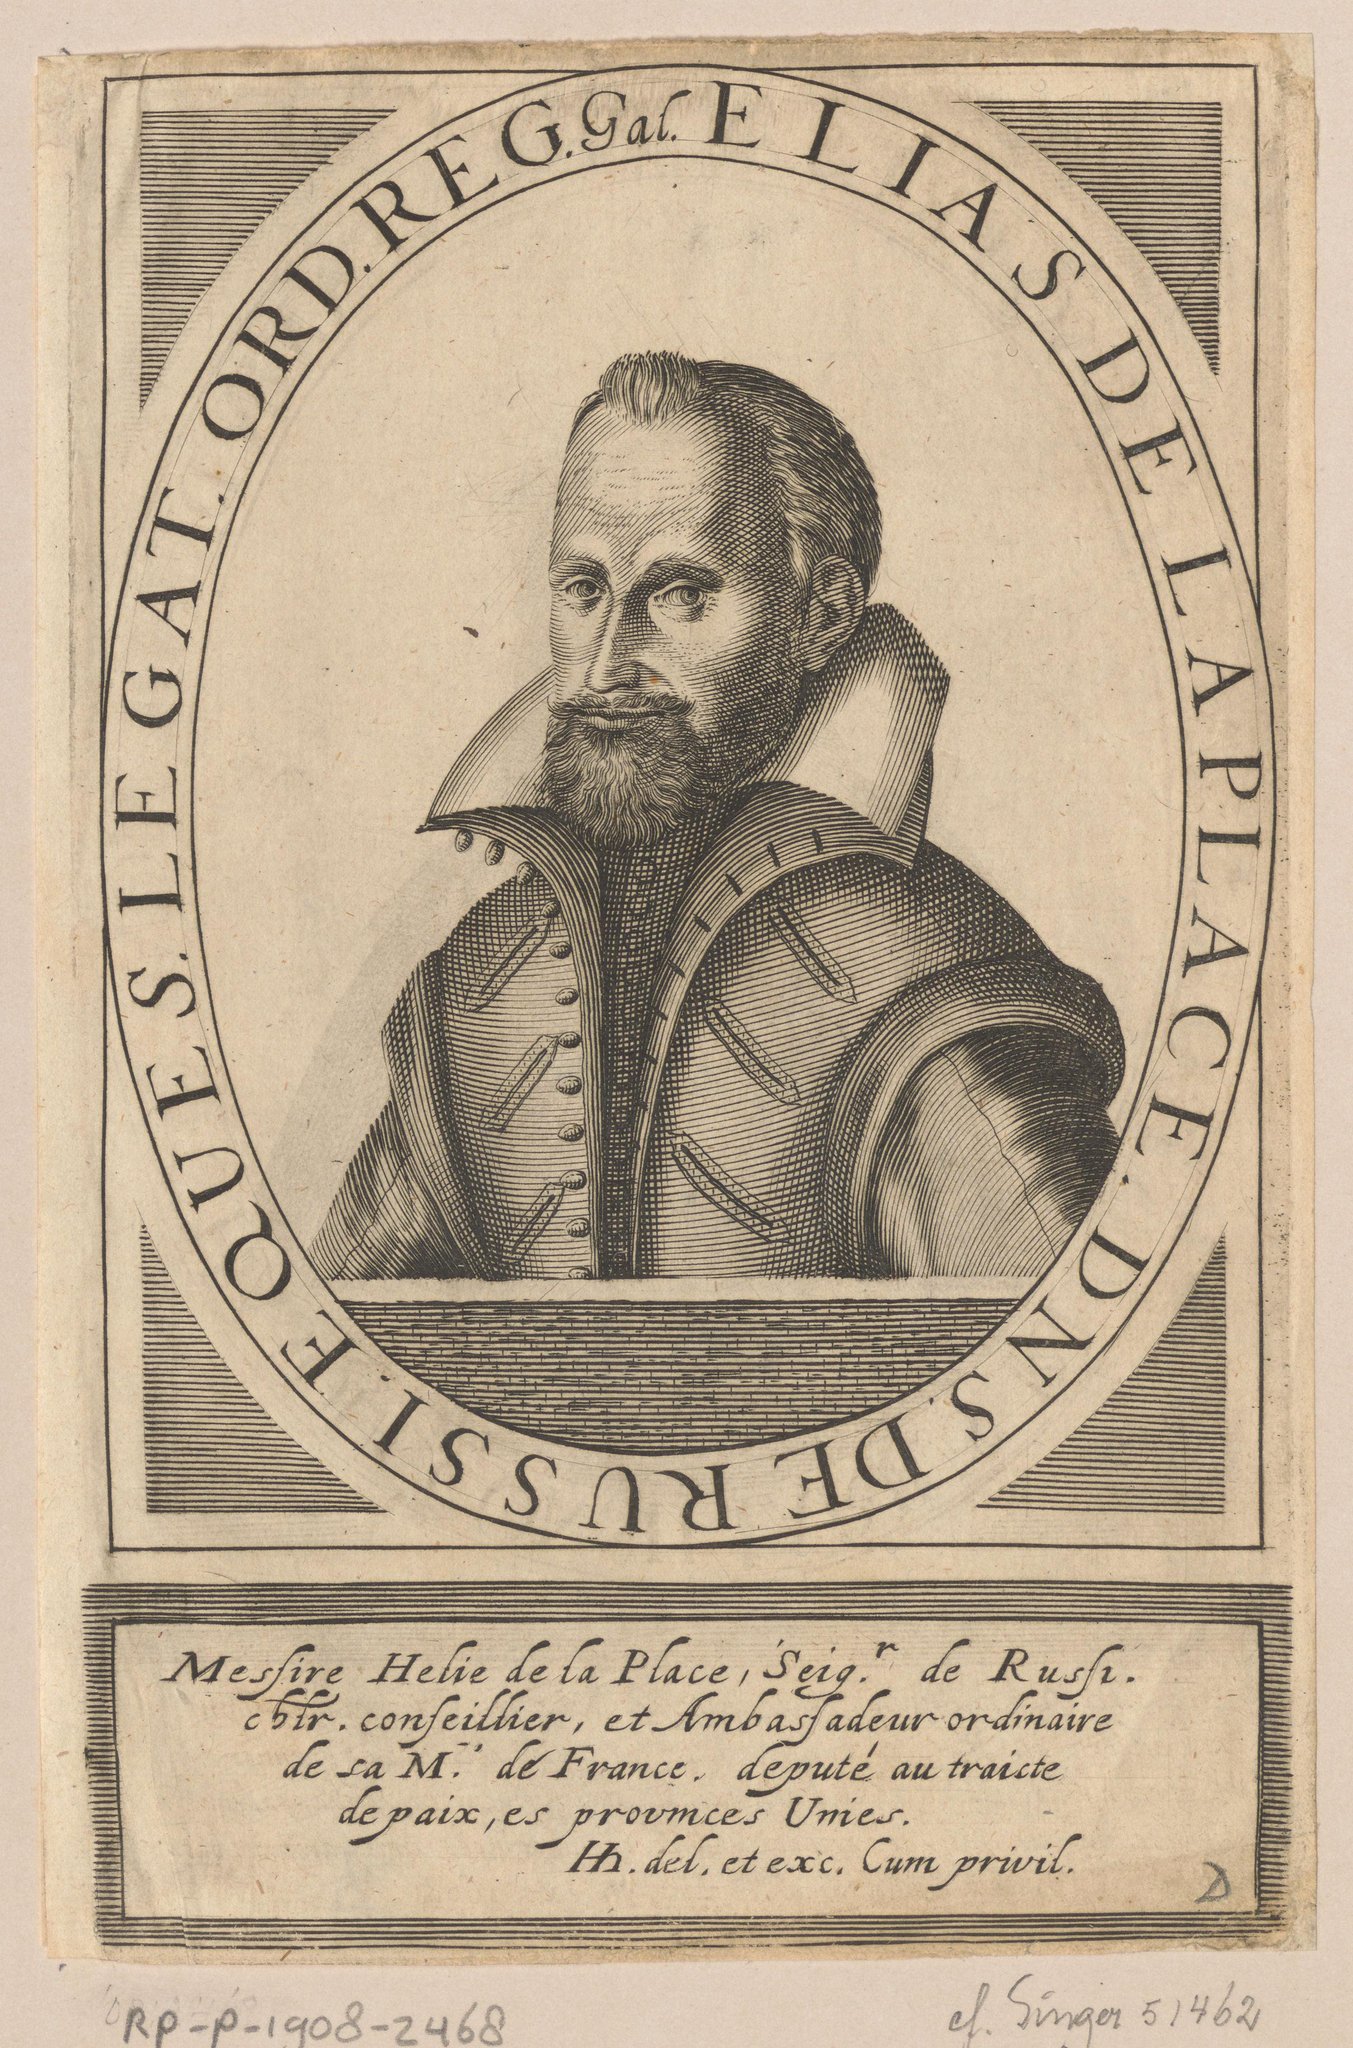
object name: print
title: Portretten van bemiddelaars van het Twaalfjarig Bestand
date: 1608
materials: paper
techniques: engraving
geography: the hague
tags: historical persons, ambassador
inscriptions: collector's mark: Lugt 2228